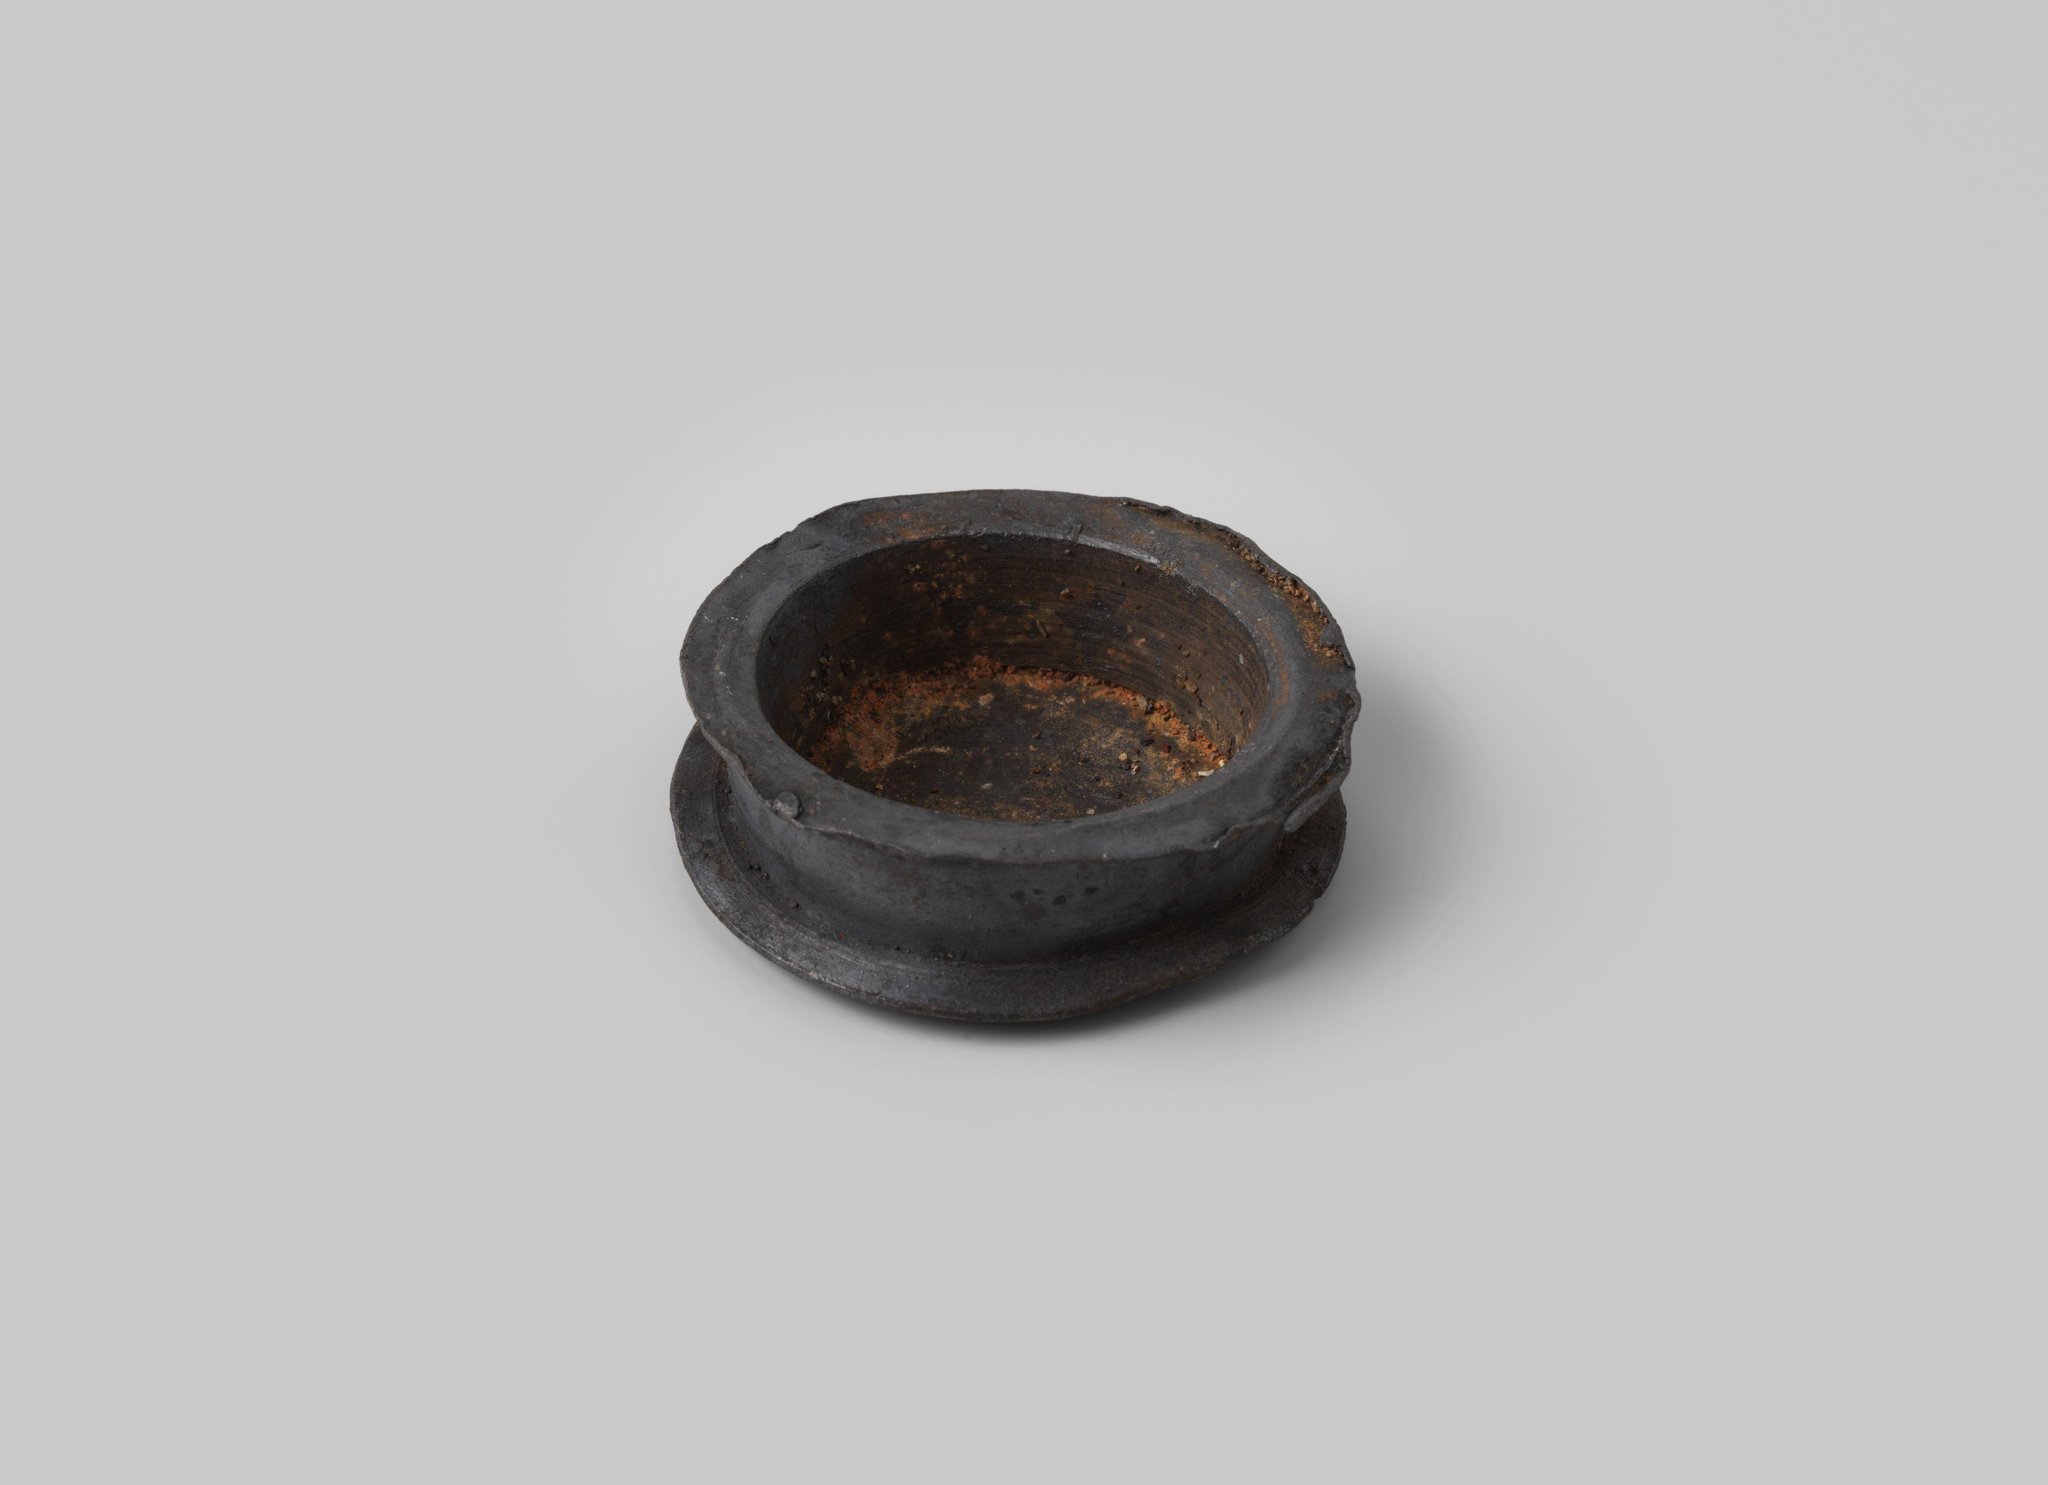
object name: screwcap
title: Schroefdop uit het wrak van de Oost-Indiëvaarder Princesse Maria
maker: Anonymous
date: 1670-1686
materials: tin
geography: netherlands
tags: princesse maria (schip), verenigde oostindische compagnie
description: Ronde tinnen schroefdop voor een kelderfles, zwart gecorrodeerd. Screw cap.